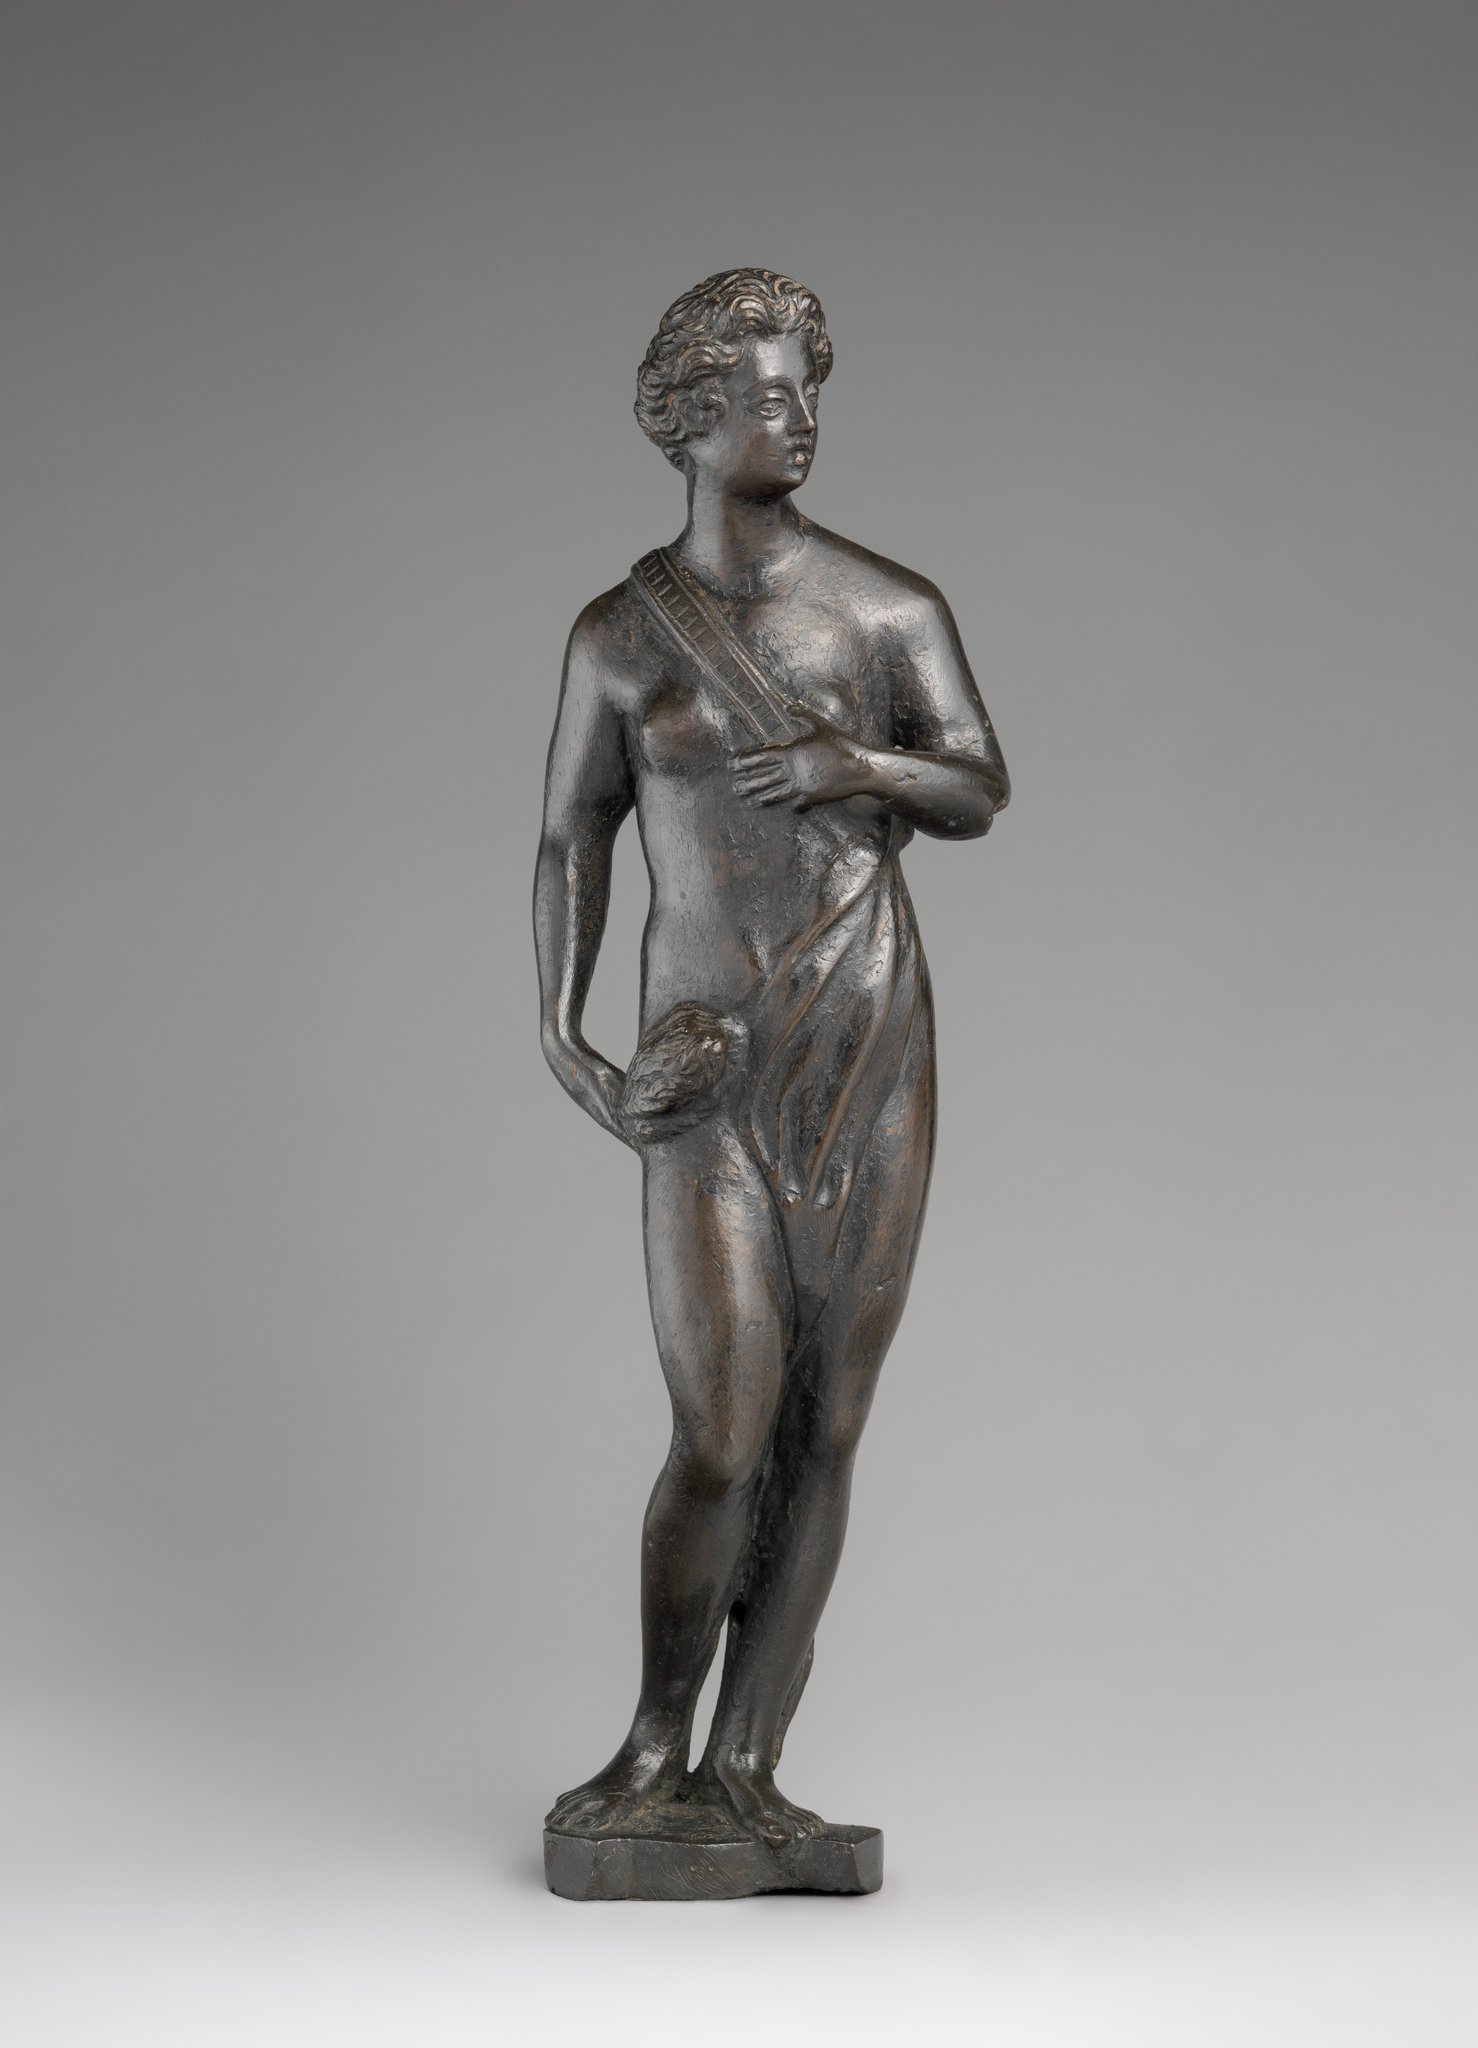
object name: statuette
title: Ceres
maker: girolamo campagna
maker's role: artist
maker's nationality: italian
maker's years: 1549-1625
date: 1567-1633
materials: bronze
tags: ceres